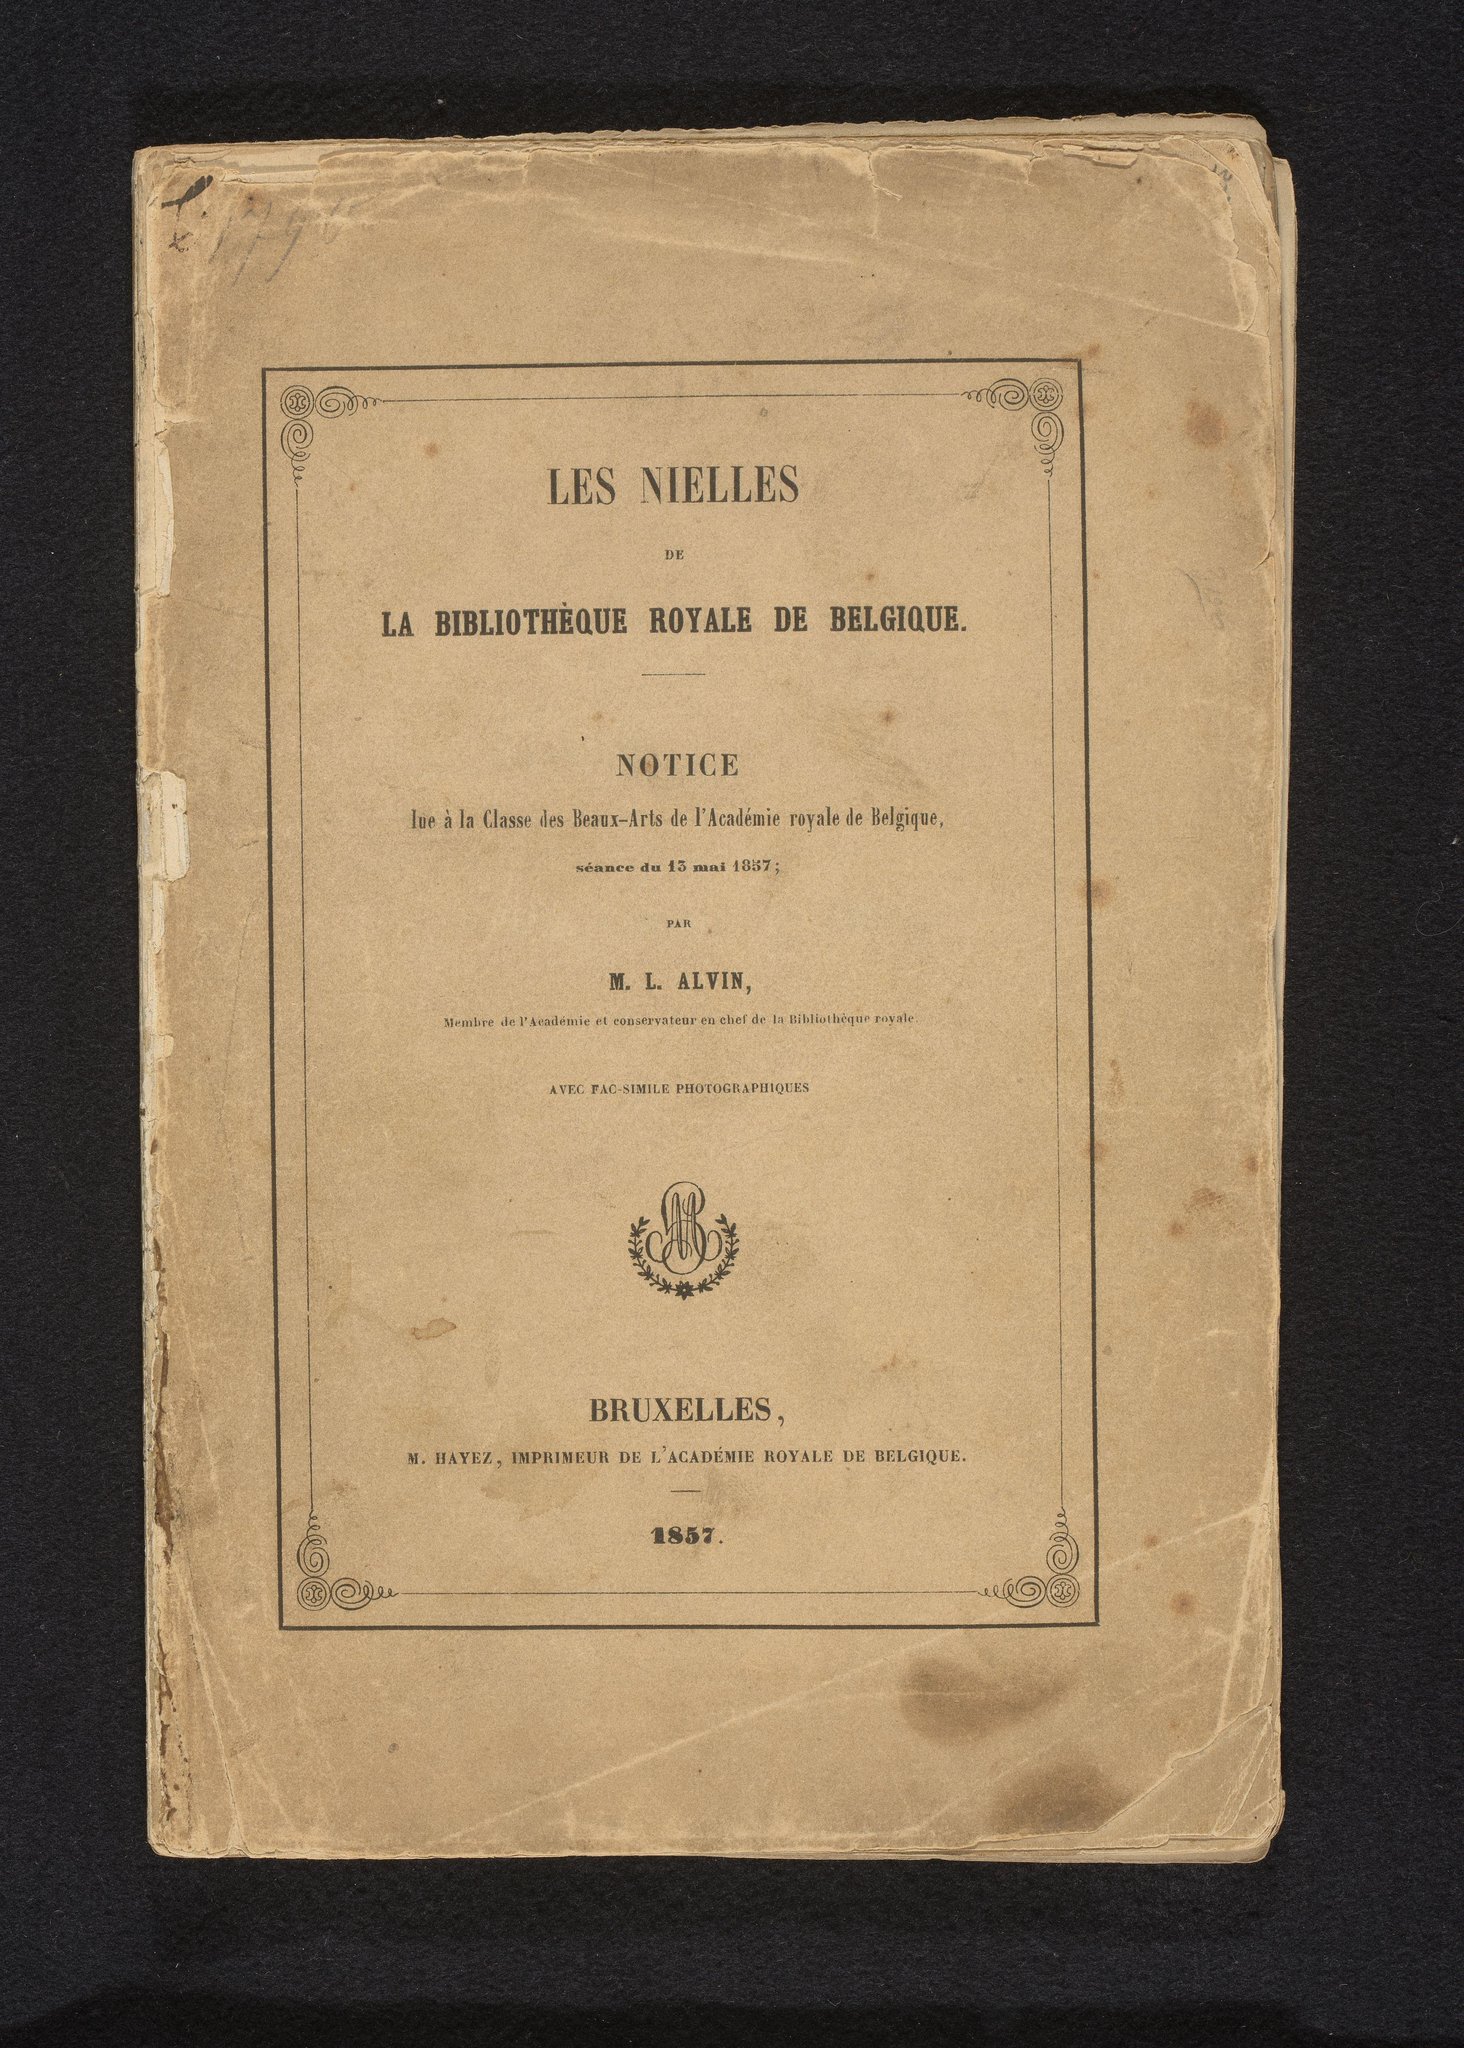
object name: book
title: Les nielles de la bibliothèque royale de Belgique / L. Alvin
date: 1857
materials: paper, photographic support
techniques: printing, salted paper print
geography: brussels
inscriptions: annotation: ‘£ 1790’